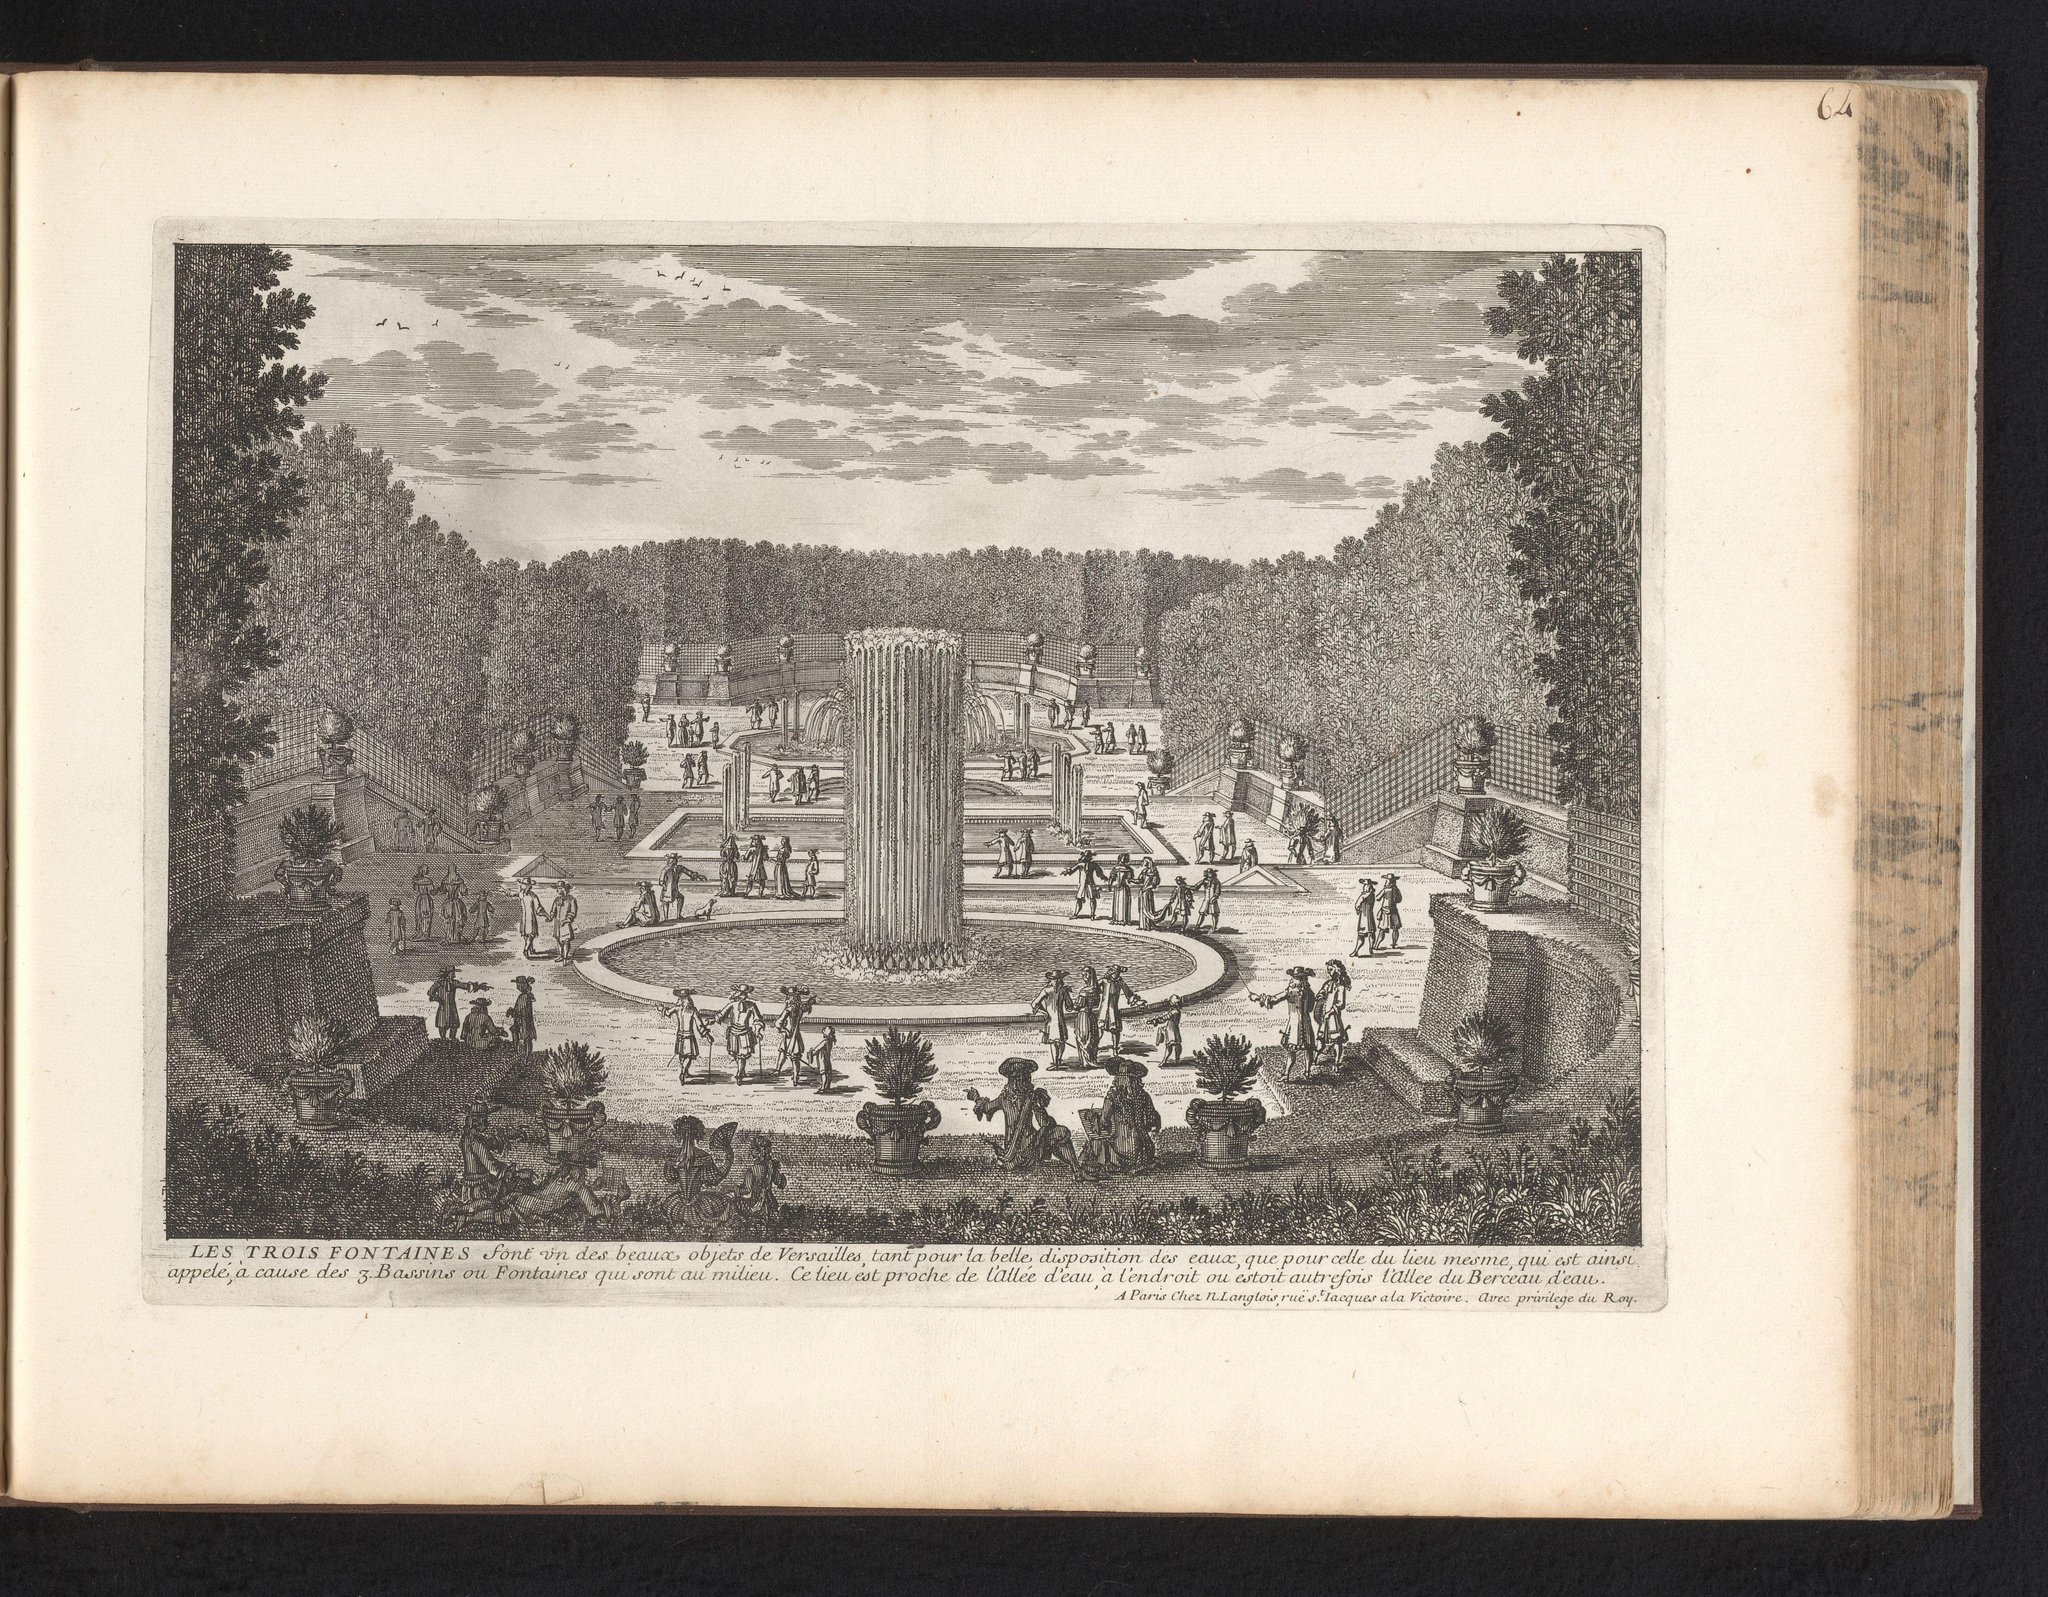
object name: album leaf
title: Stadsgezichten en landschappen in Frankrijk en Italië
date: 1677-1703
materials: paper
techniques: etching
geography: france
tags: garden fountain, french or architectonic garden; formal garden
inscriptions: collector's mark: Lugt 2228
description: Prenten met het signatuur 'Perelle' kunnen zowel door vader Gabriel als door zonen Nicolas en Adam gemaakt zijn. De uitgevers vader en zoon Nicolas Langlois worden allebei vermeld als N. Langlois op hetzelfde adres.